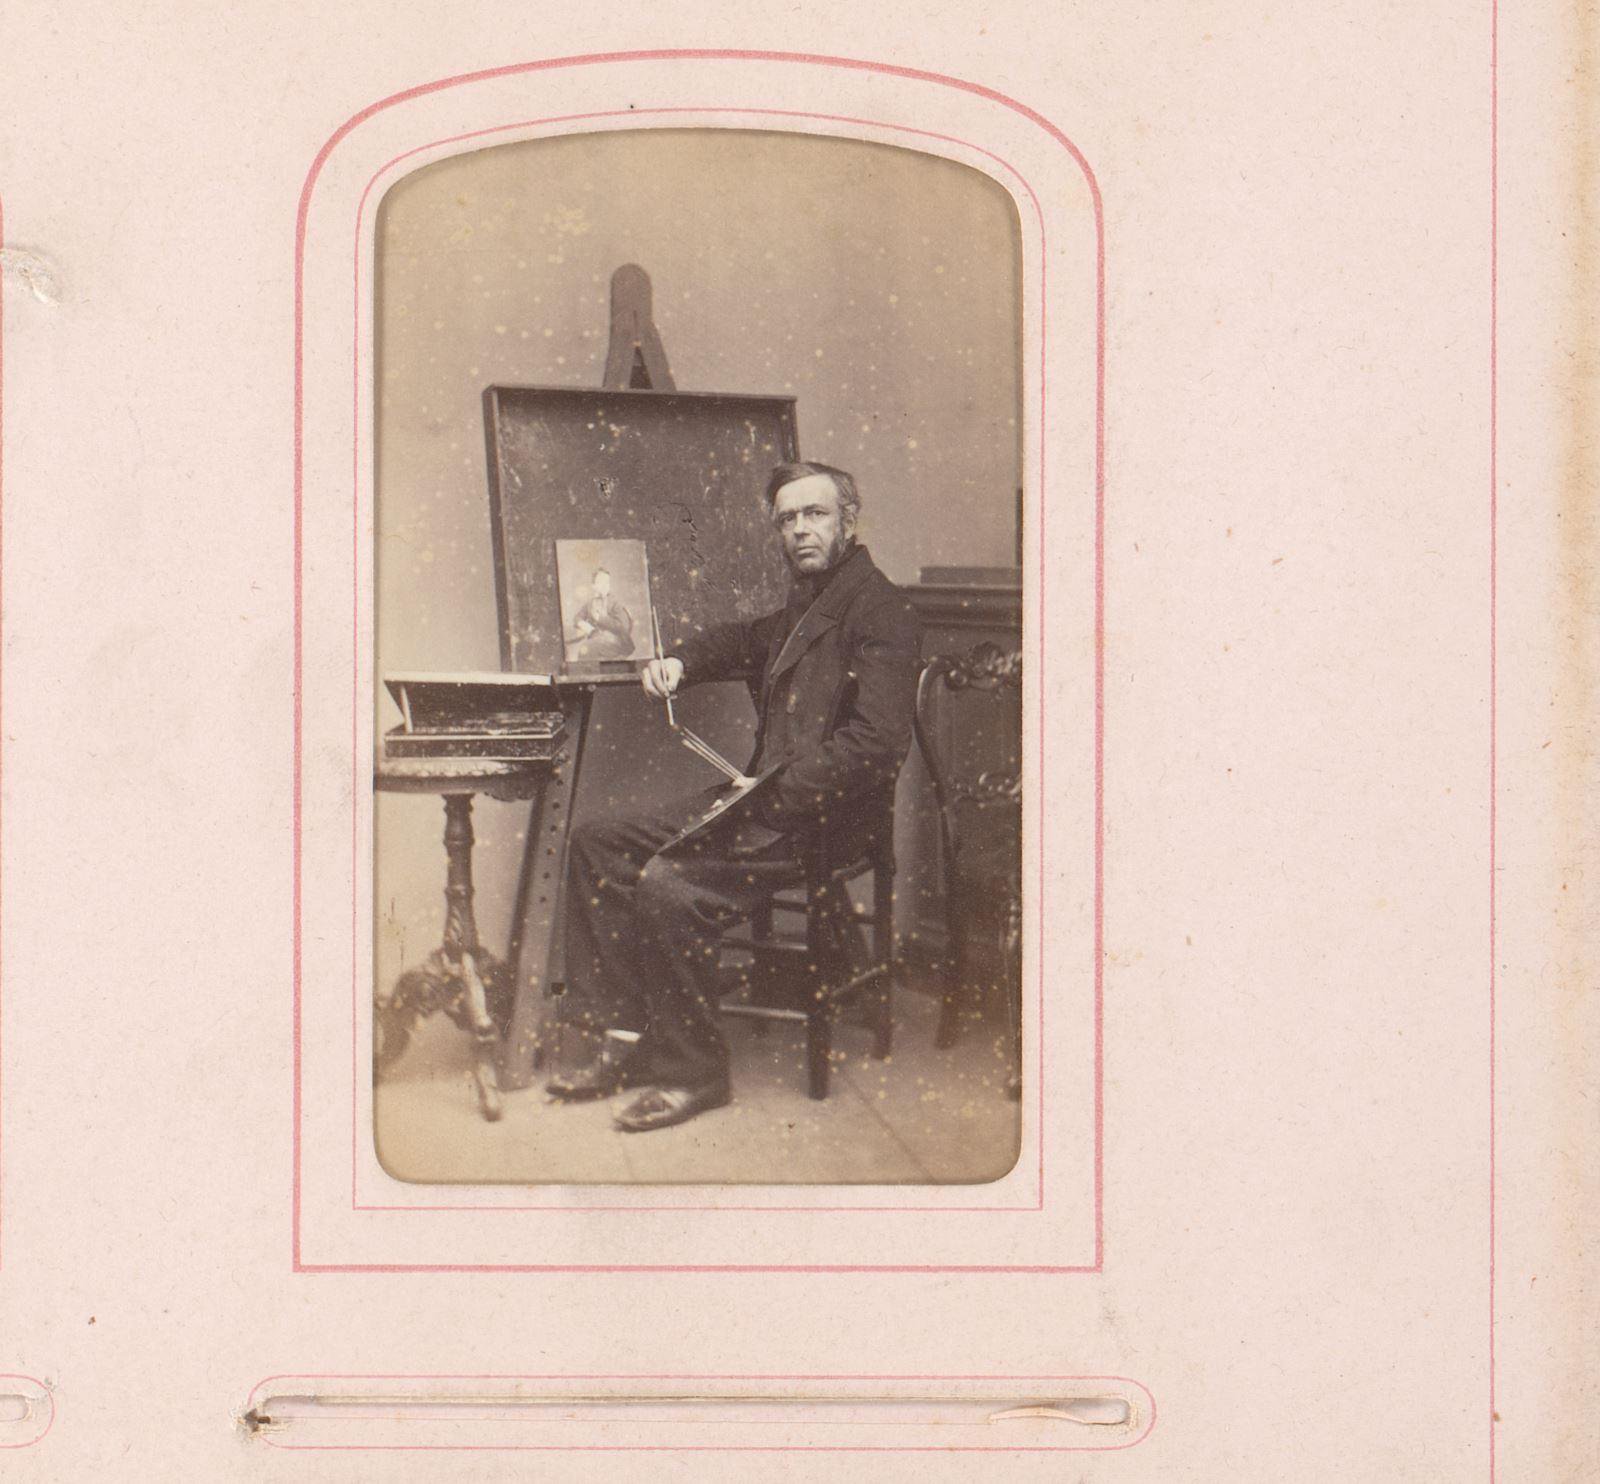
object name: photograph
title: Portret kunstschilder aan ezel met portret, palet en penselen, verfdoos op tafeltje (zelfportret Leonard de Koningh?)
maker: leonard de koningh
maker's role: draughtsman, painter, print maker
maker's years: 1810-1887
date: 1864-1879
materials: cardboard, paper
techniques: albumen print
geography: dordrecht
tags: dordrecht, painter, adult man, historical persons, painter at work, in his studio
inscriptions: inscription: ‘L. de Koningh,/ Dordrecht.’